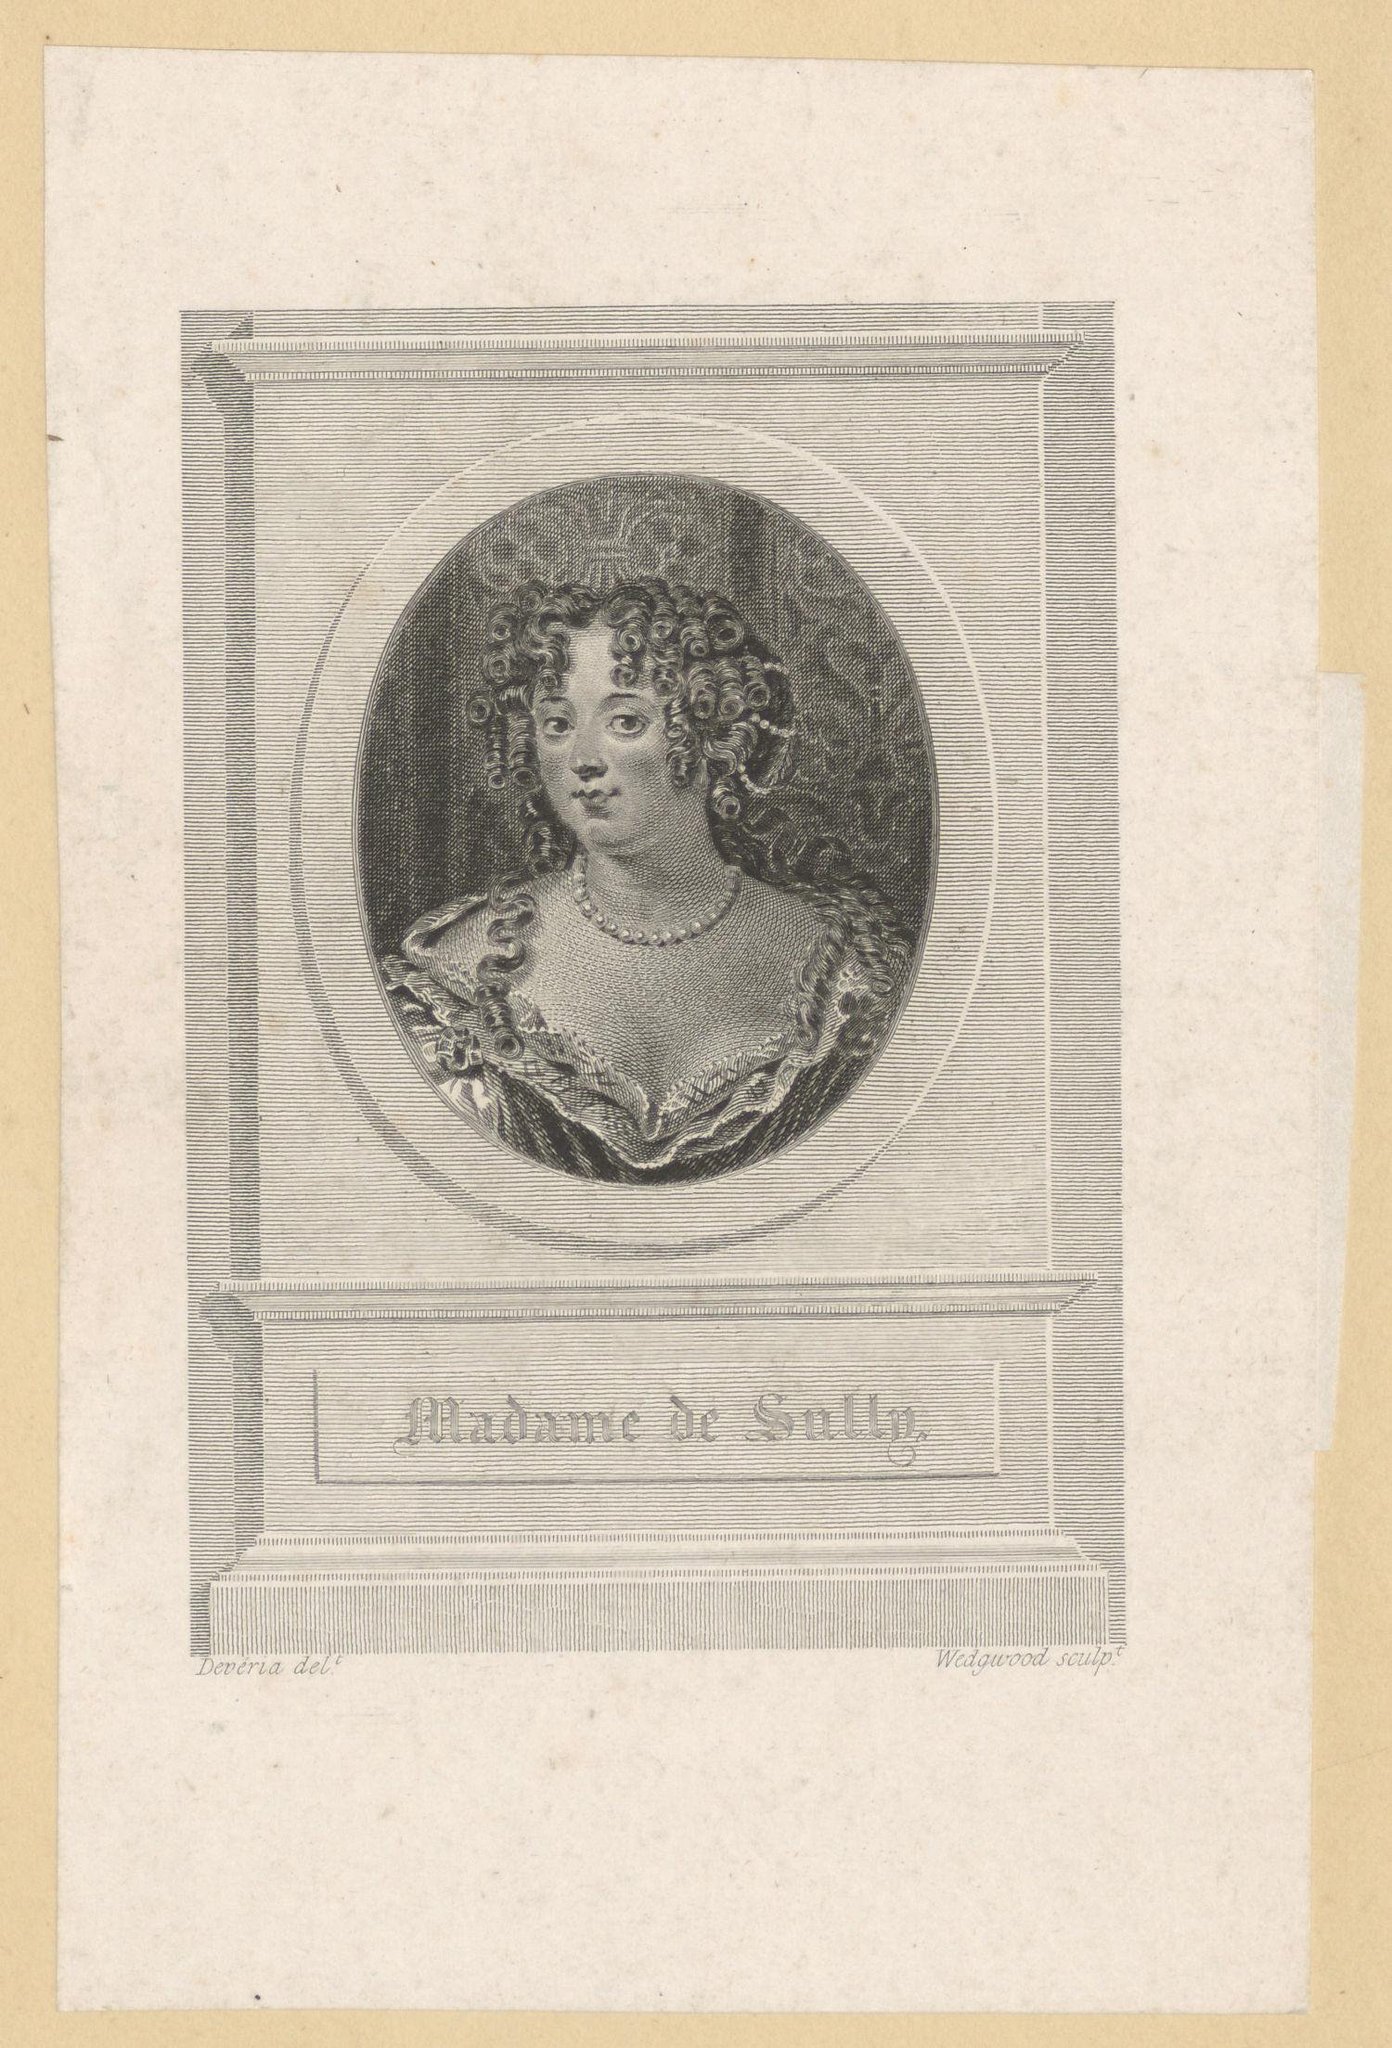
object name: book illustration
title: Portret van Madeleine Armande de Cambout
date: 1829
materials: paper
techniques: etching, letterpress printing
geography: paris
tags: historical persons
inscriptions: collector's mark: Lugt 2228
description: Prent uit: Devéria, Dieu. Collection de 25 portraits des personnages les plus célèbres du Siècle de Louis XIV (...). Parijs: Lemarchand, 1829.